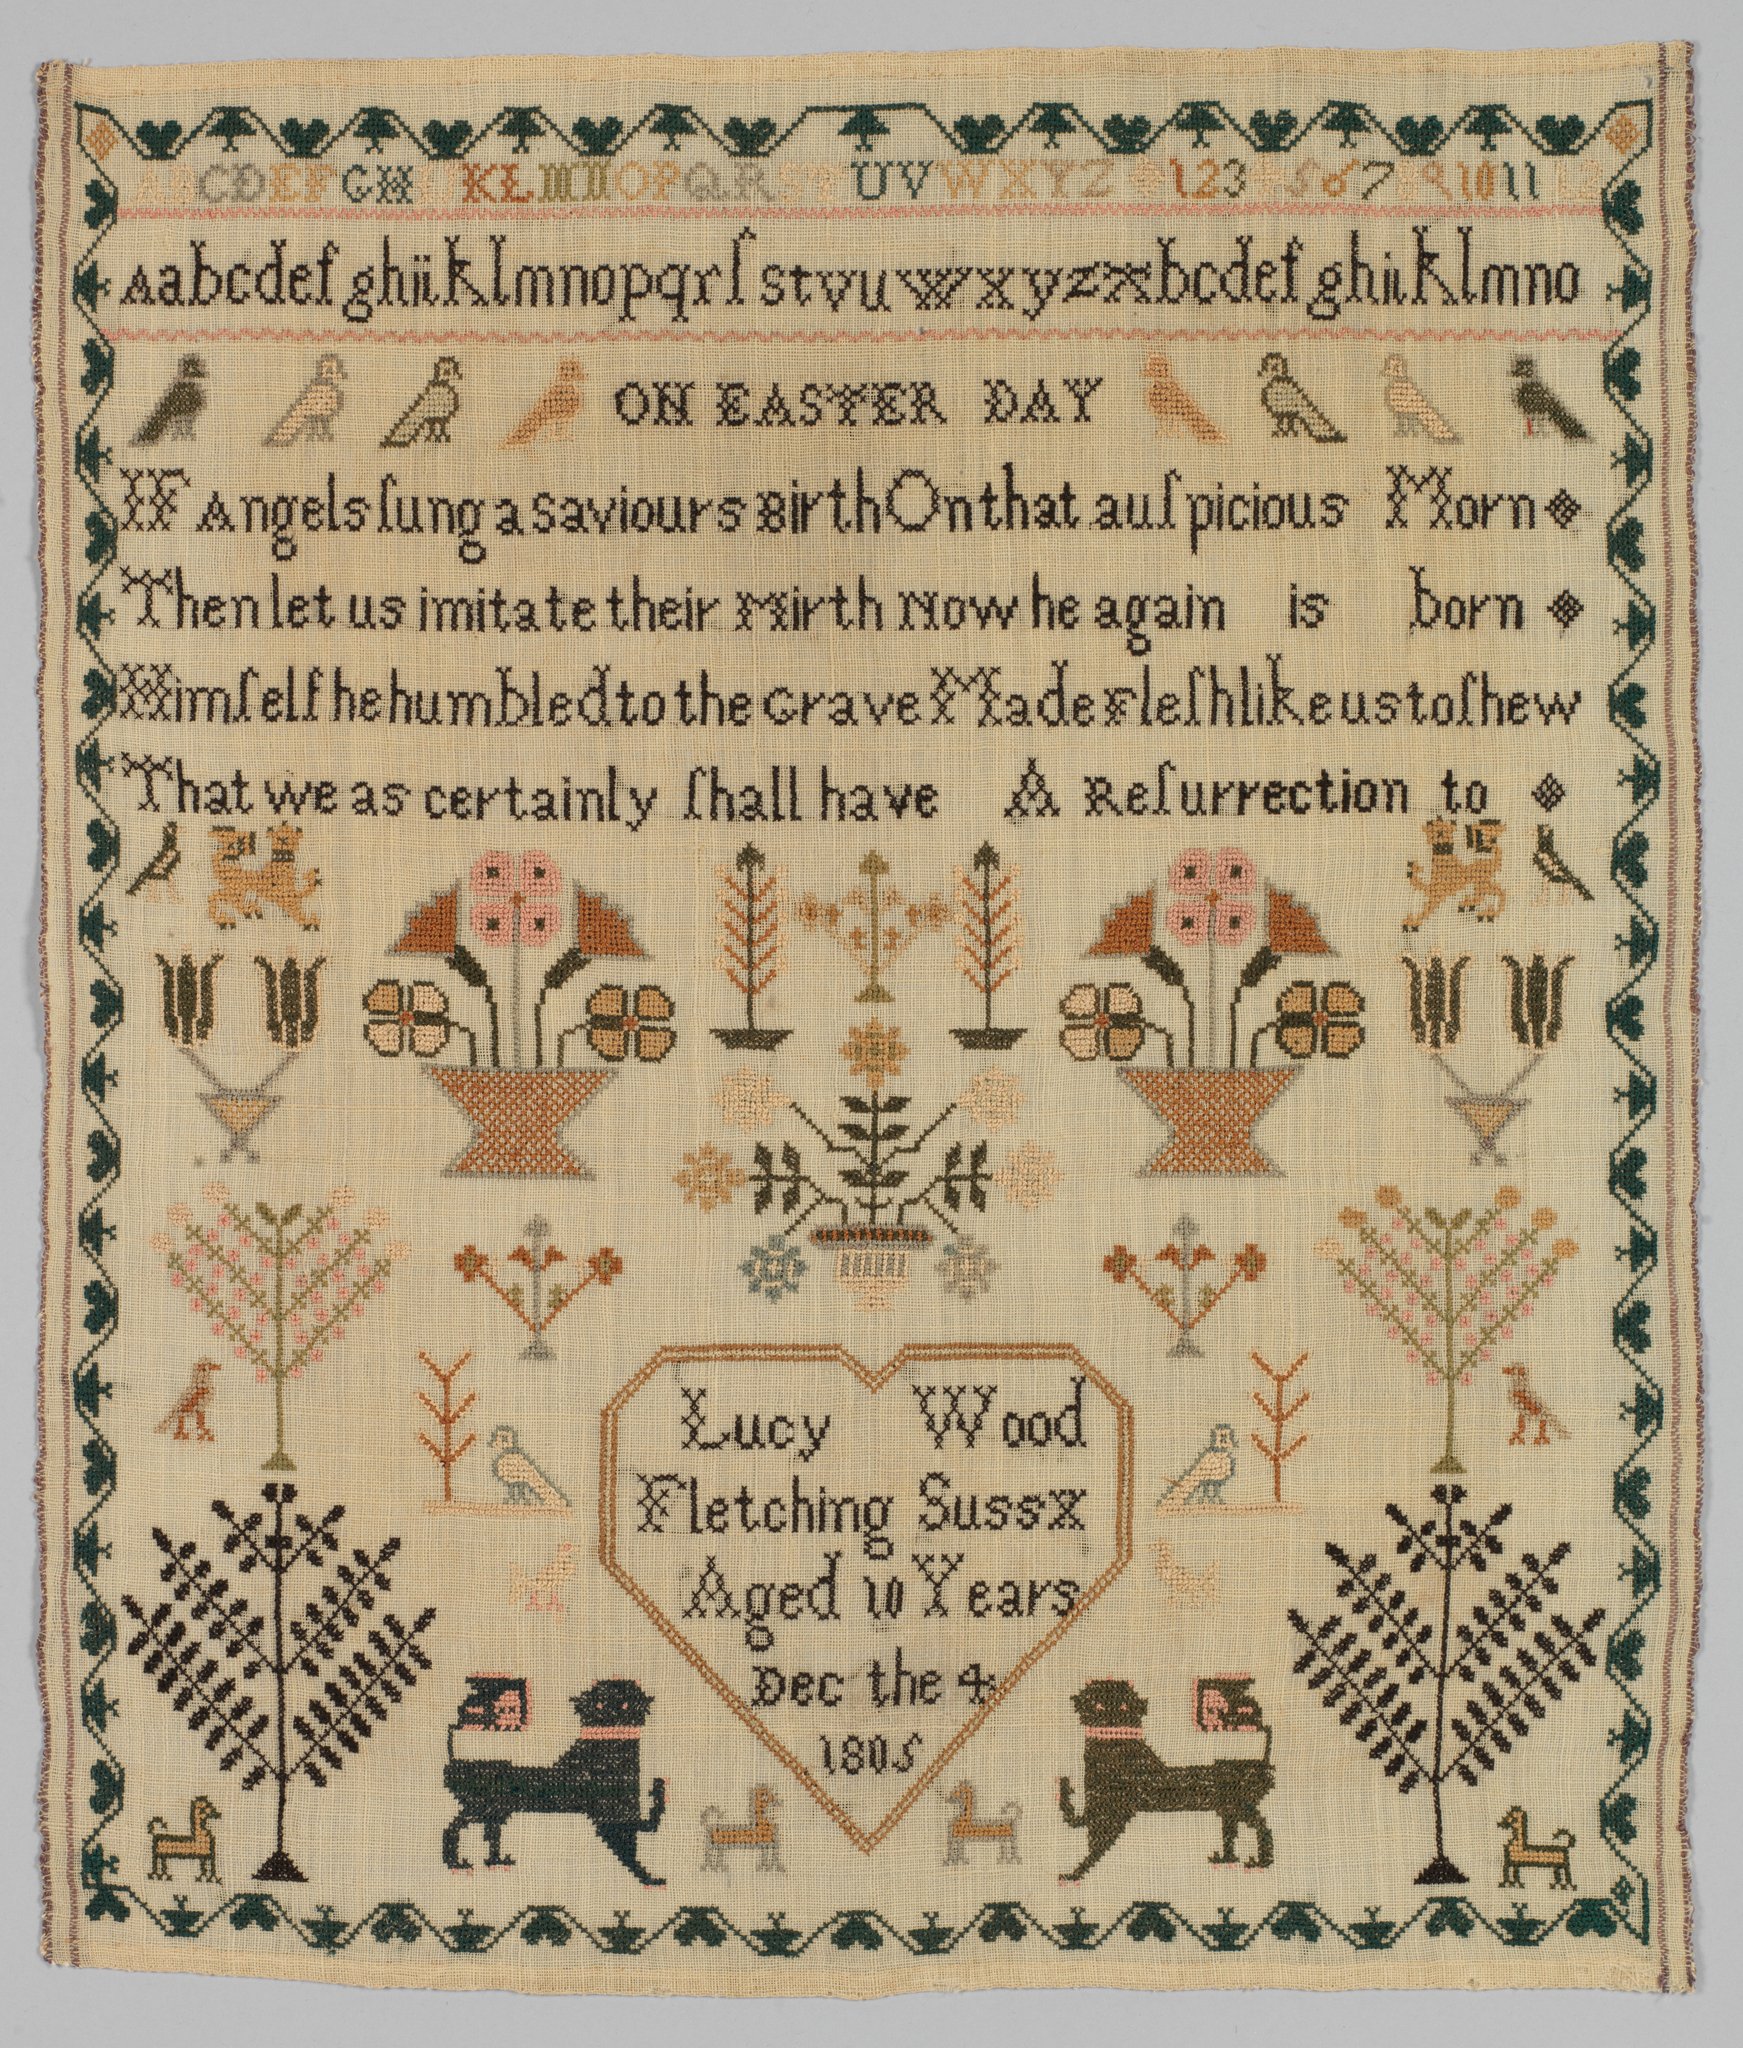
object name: sampler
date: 1805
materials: canvas, silk, wool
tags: birds,dogs,flowers